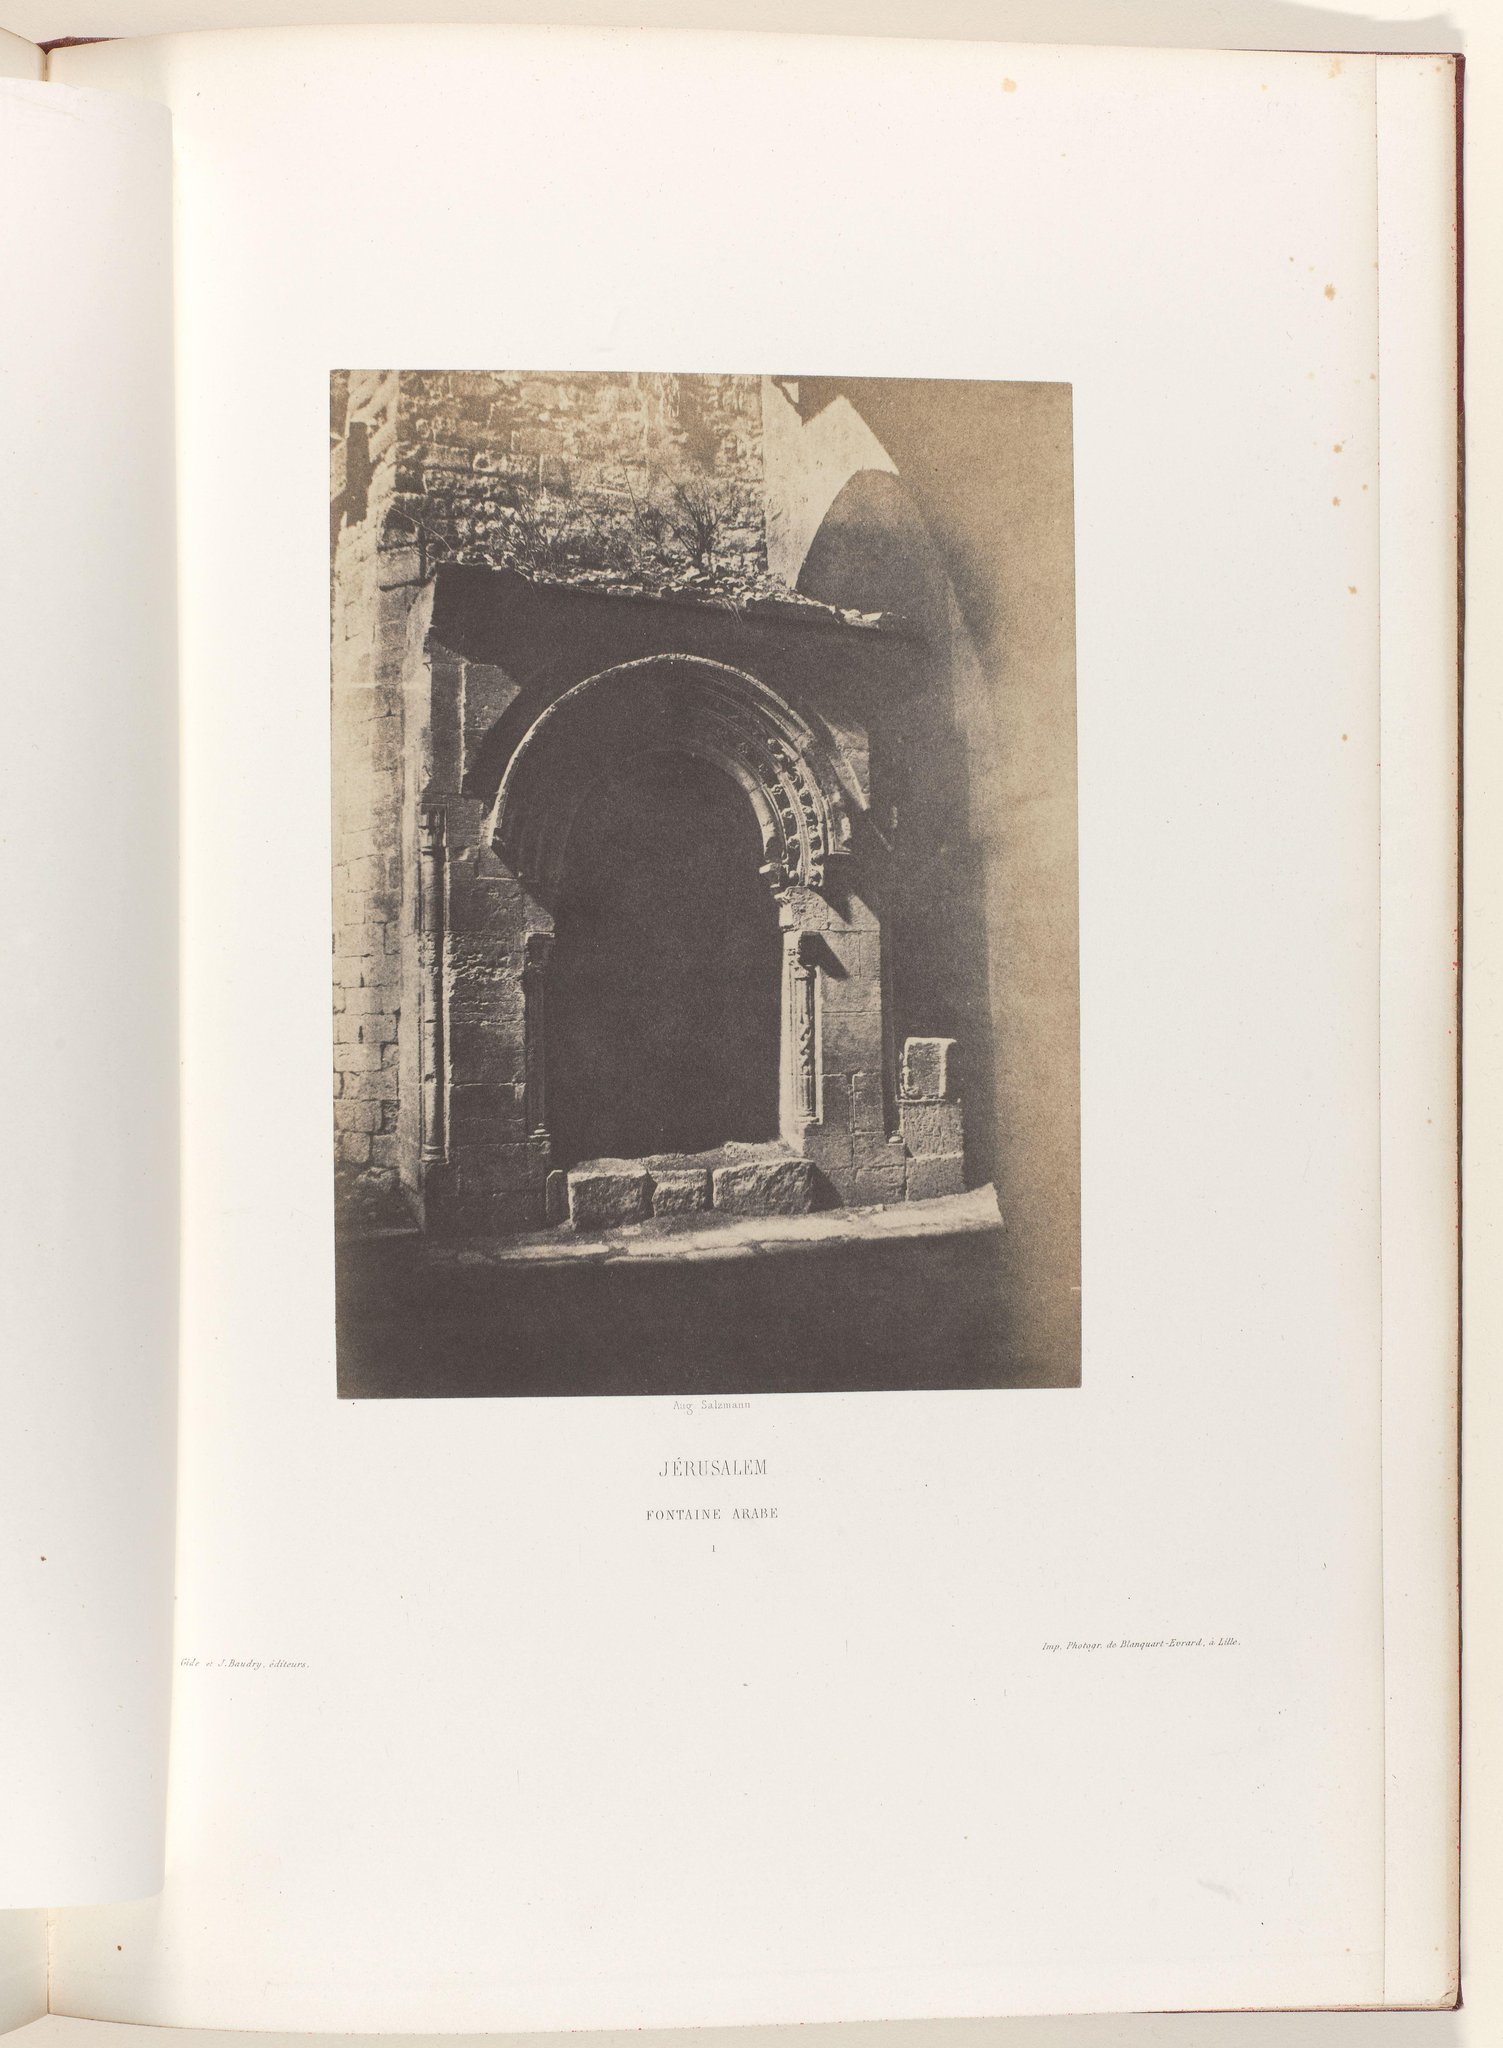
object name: page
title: Jérusalem. Fontaine Arabe. 1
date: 1854-1856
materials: cardboard, paper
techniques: salted paper print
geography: lille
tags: ornamental fountain